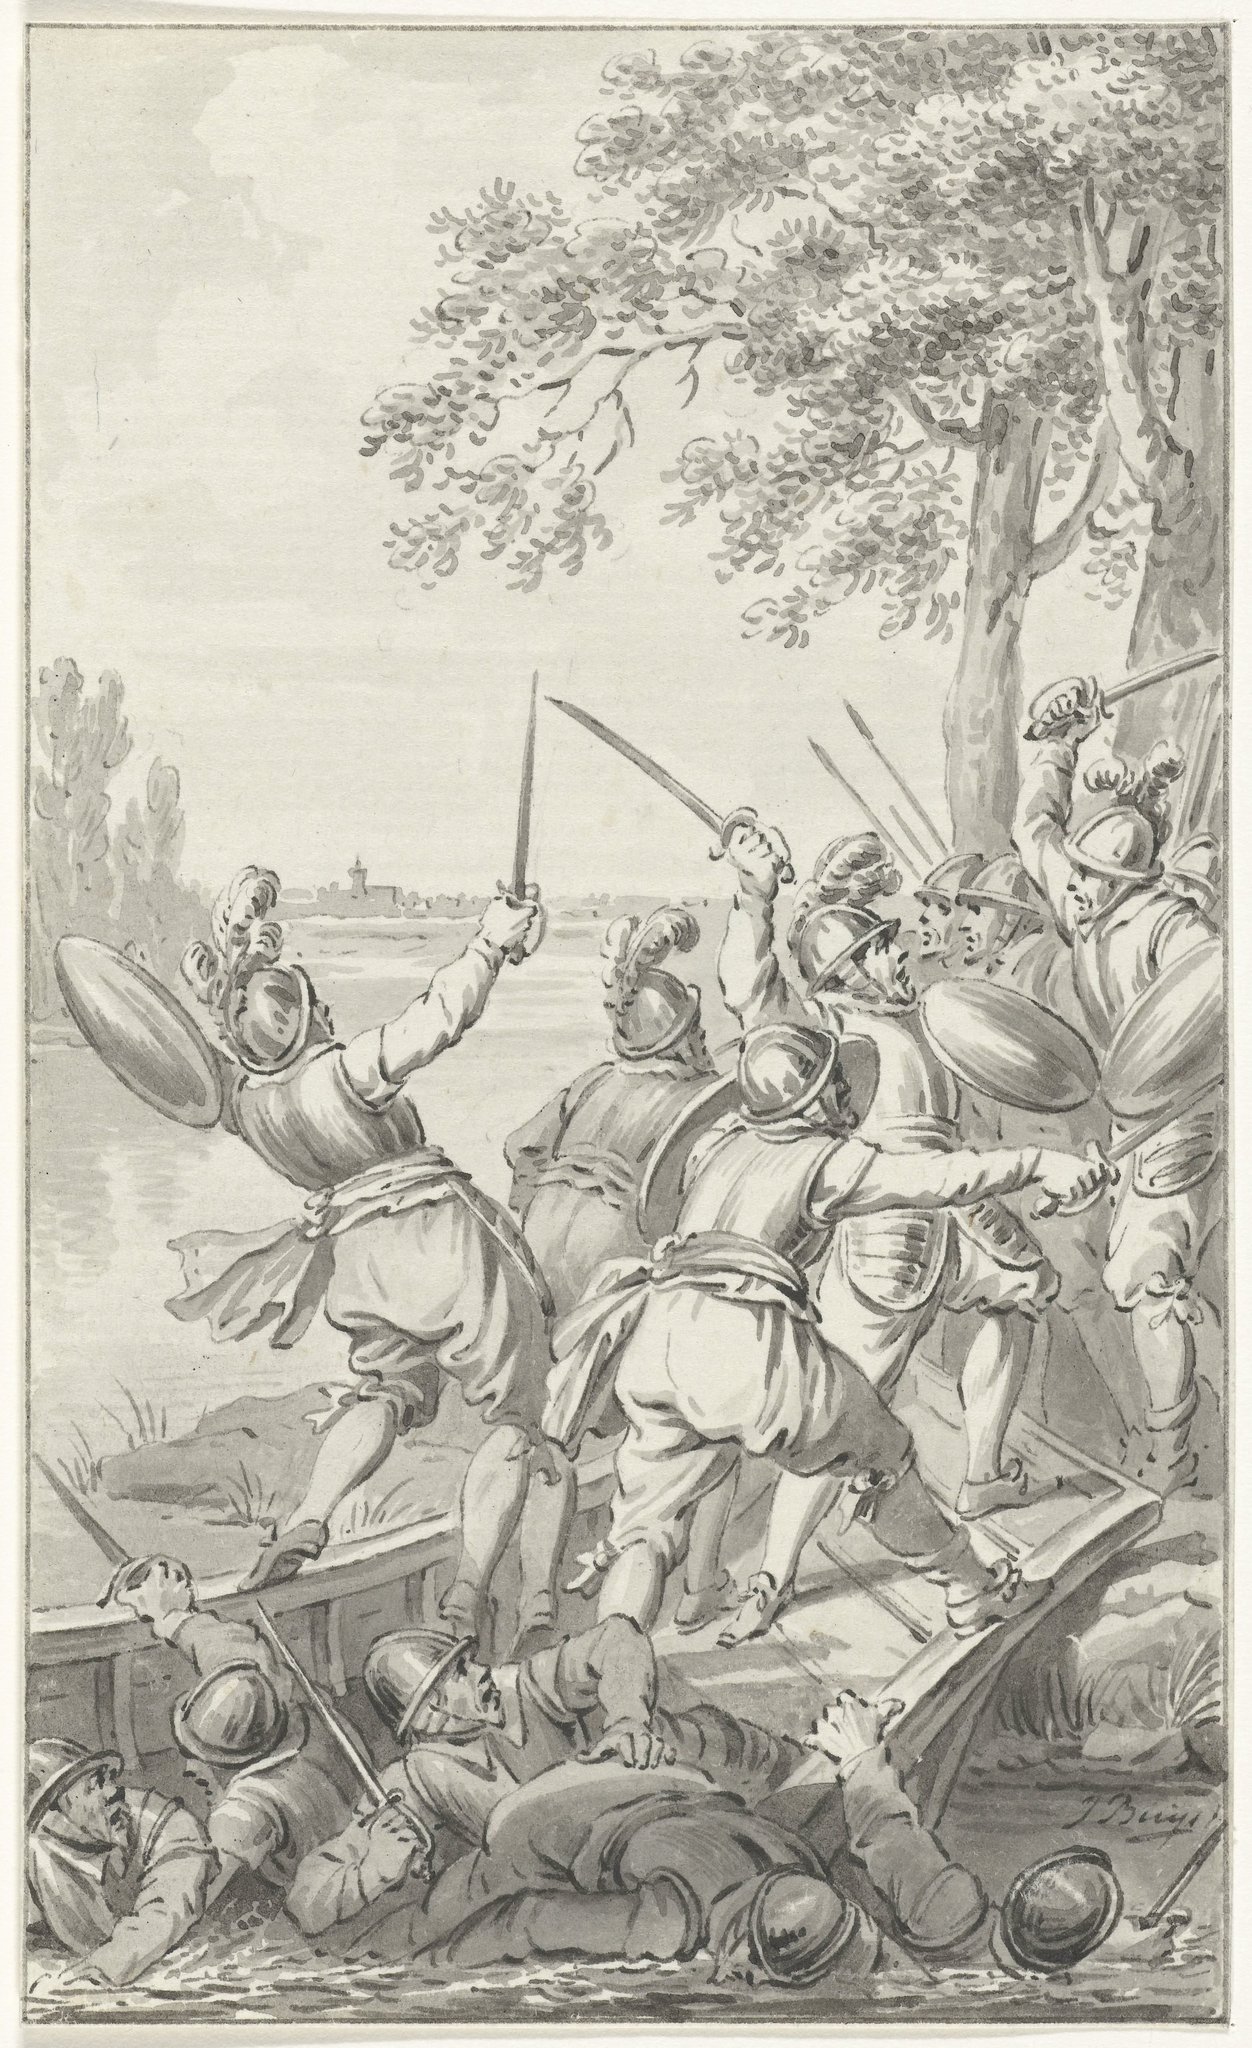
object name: drawing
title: Arent van Benschop en Jan van Renesse verdrinken in de Lek, 1304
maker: jacobus buys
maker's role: draughtsman, print maker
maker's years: 1724-1801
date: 1785-1787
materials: ink, paper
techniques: brush, pen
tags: violent death ~ water, historical persons, historical events and situations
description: Arent van Benschop, Jan van Renesse en hun troepen verdrinken in de Lek bij Beusichem, na de nederlaag van de Vlamingen bij Zierikzee, 16 augustus 1304. Ontwerp voor een prent.